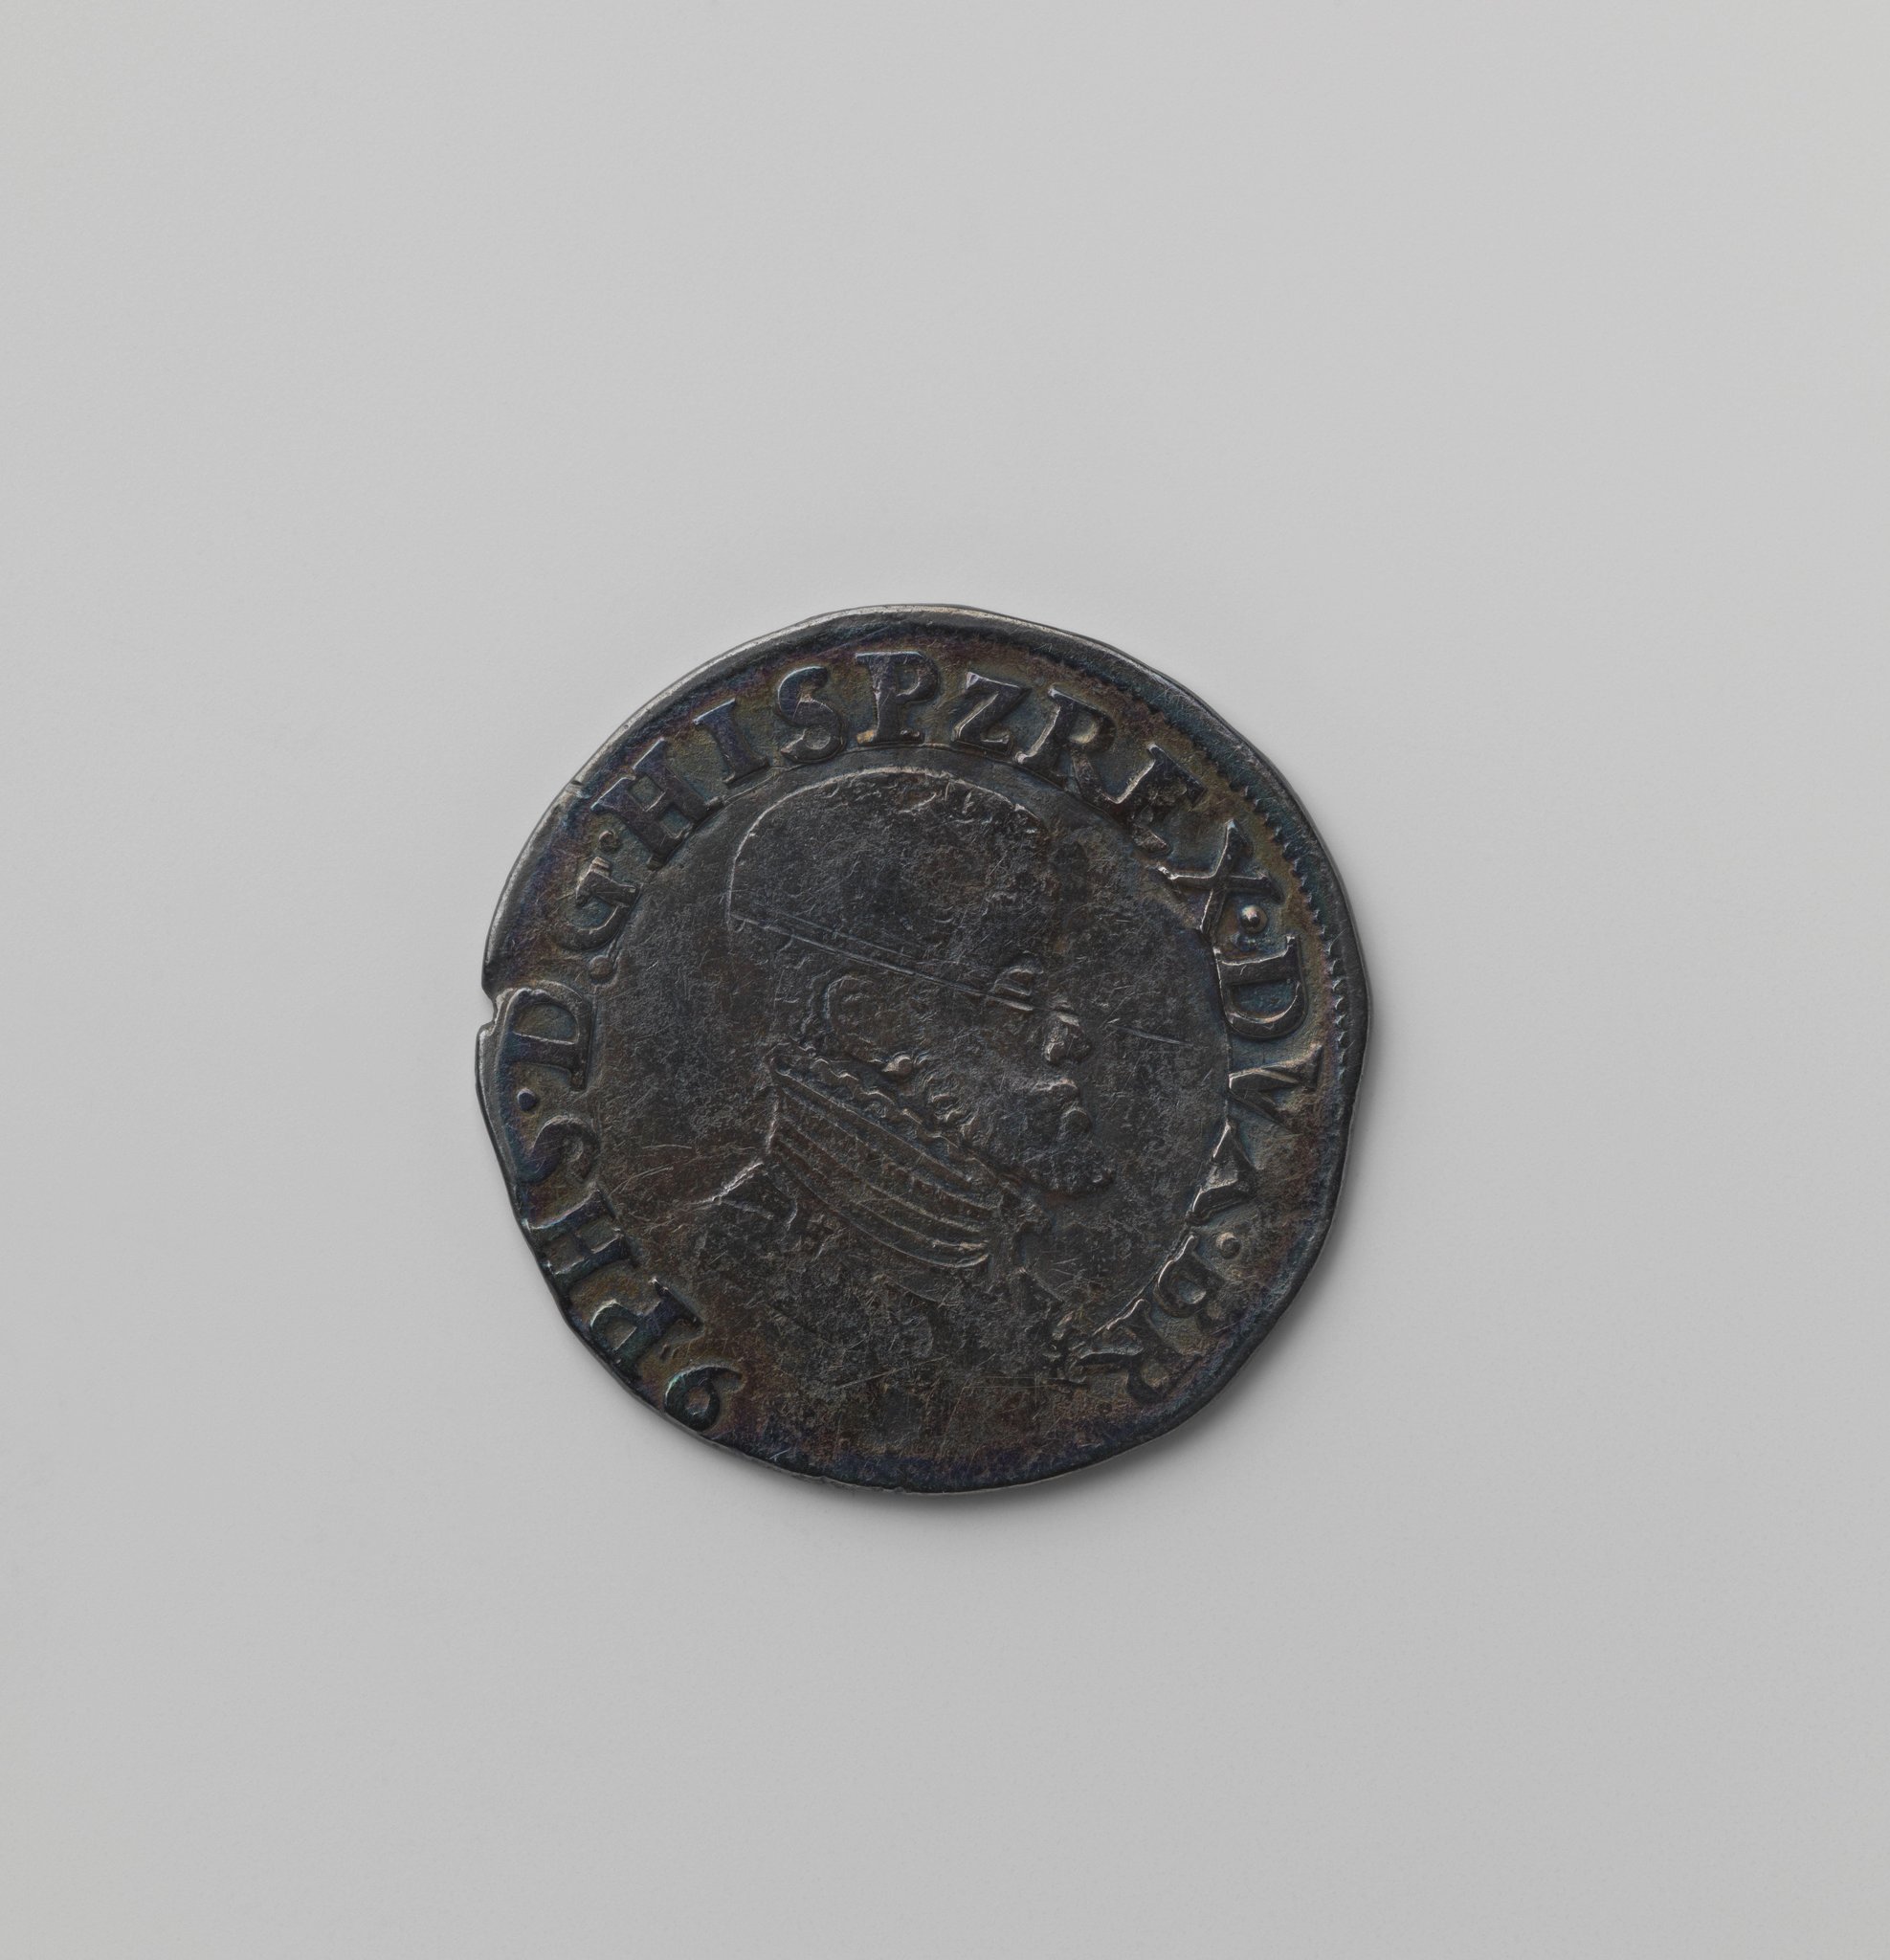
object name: coin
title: Vijfde philipsdaalder uit Brabant van Philips II, 1565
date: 1565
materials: silver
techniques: striking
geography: antwerp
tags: philip ii of spain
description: Zilveren munt. Voorzijde: hoofd van Philips II naar rechts. Jaartal 65 in omschrift.Keerzijde: tussen twee vuurijzers met vonken gekroond wapenschild op stokkenkruis.